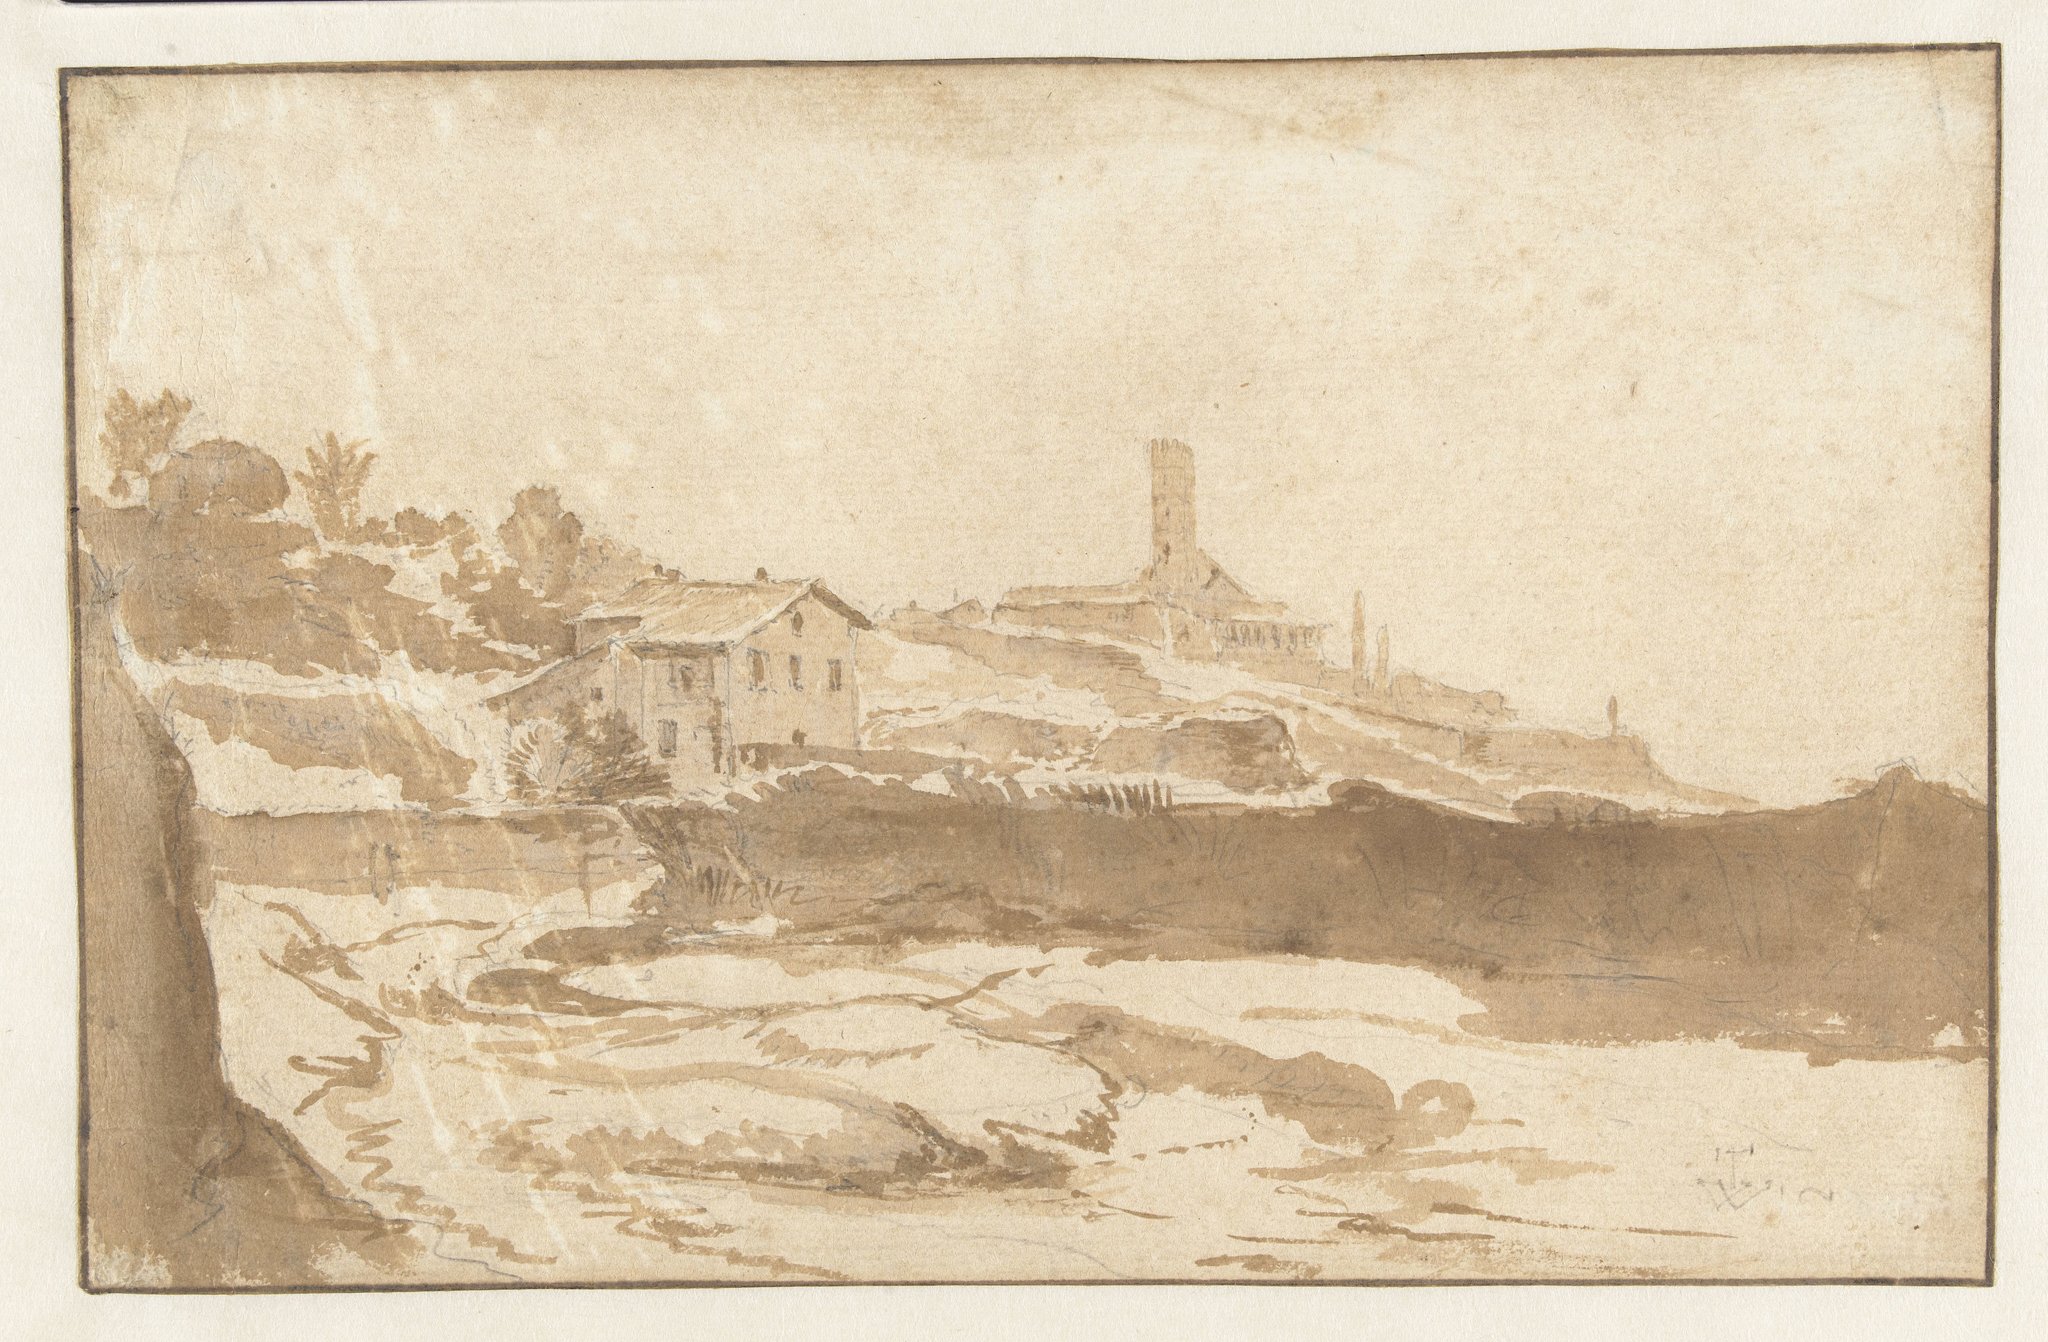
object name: drawing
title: Gezicht op de kerk van San Gregorio al Celio in Rome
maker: thomas wijck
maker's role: draughtsman, painter, print maker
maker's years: 1616-1677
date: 1626-1677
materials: graphite, ink, paper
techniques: brush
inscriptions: monogram: ‘TW’